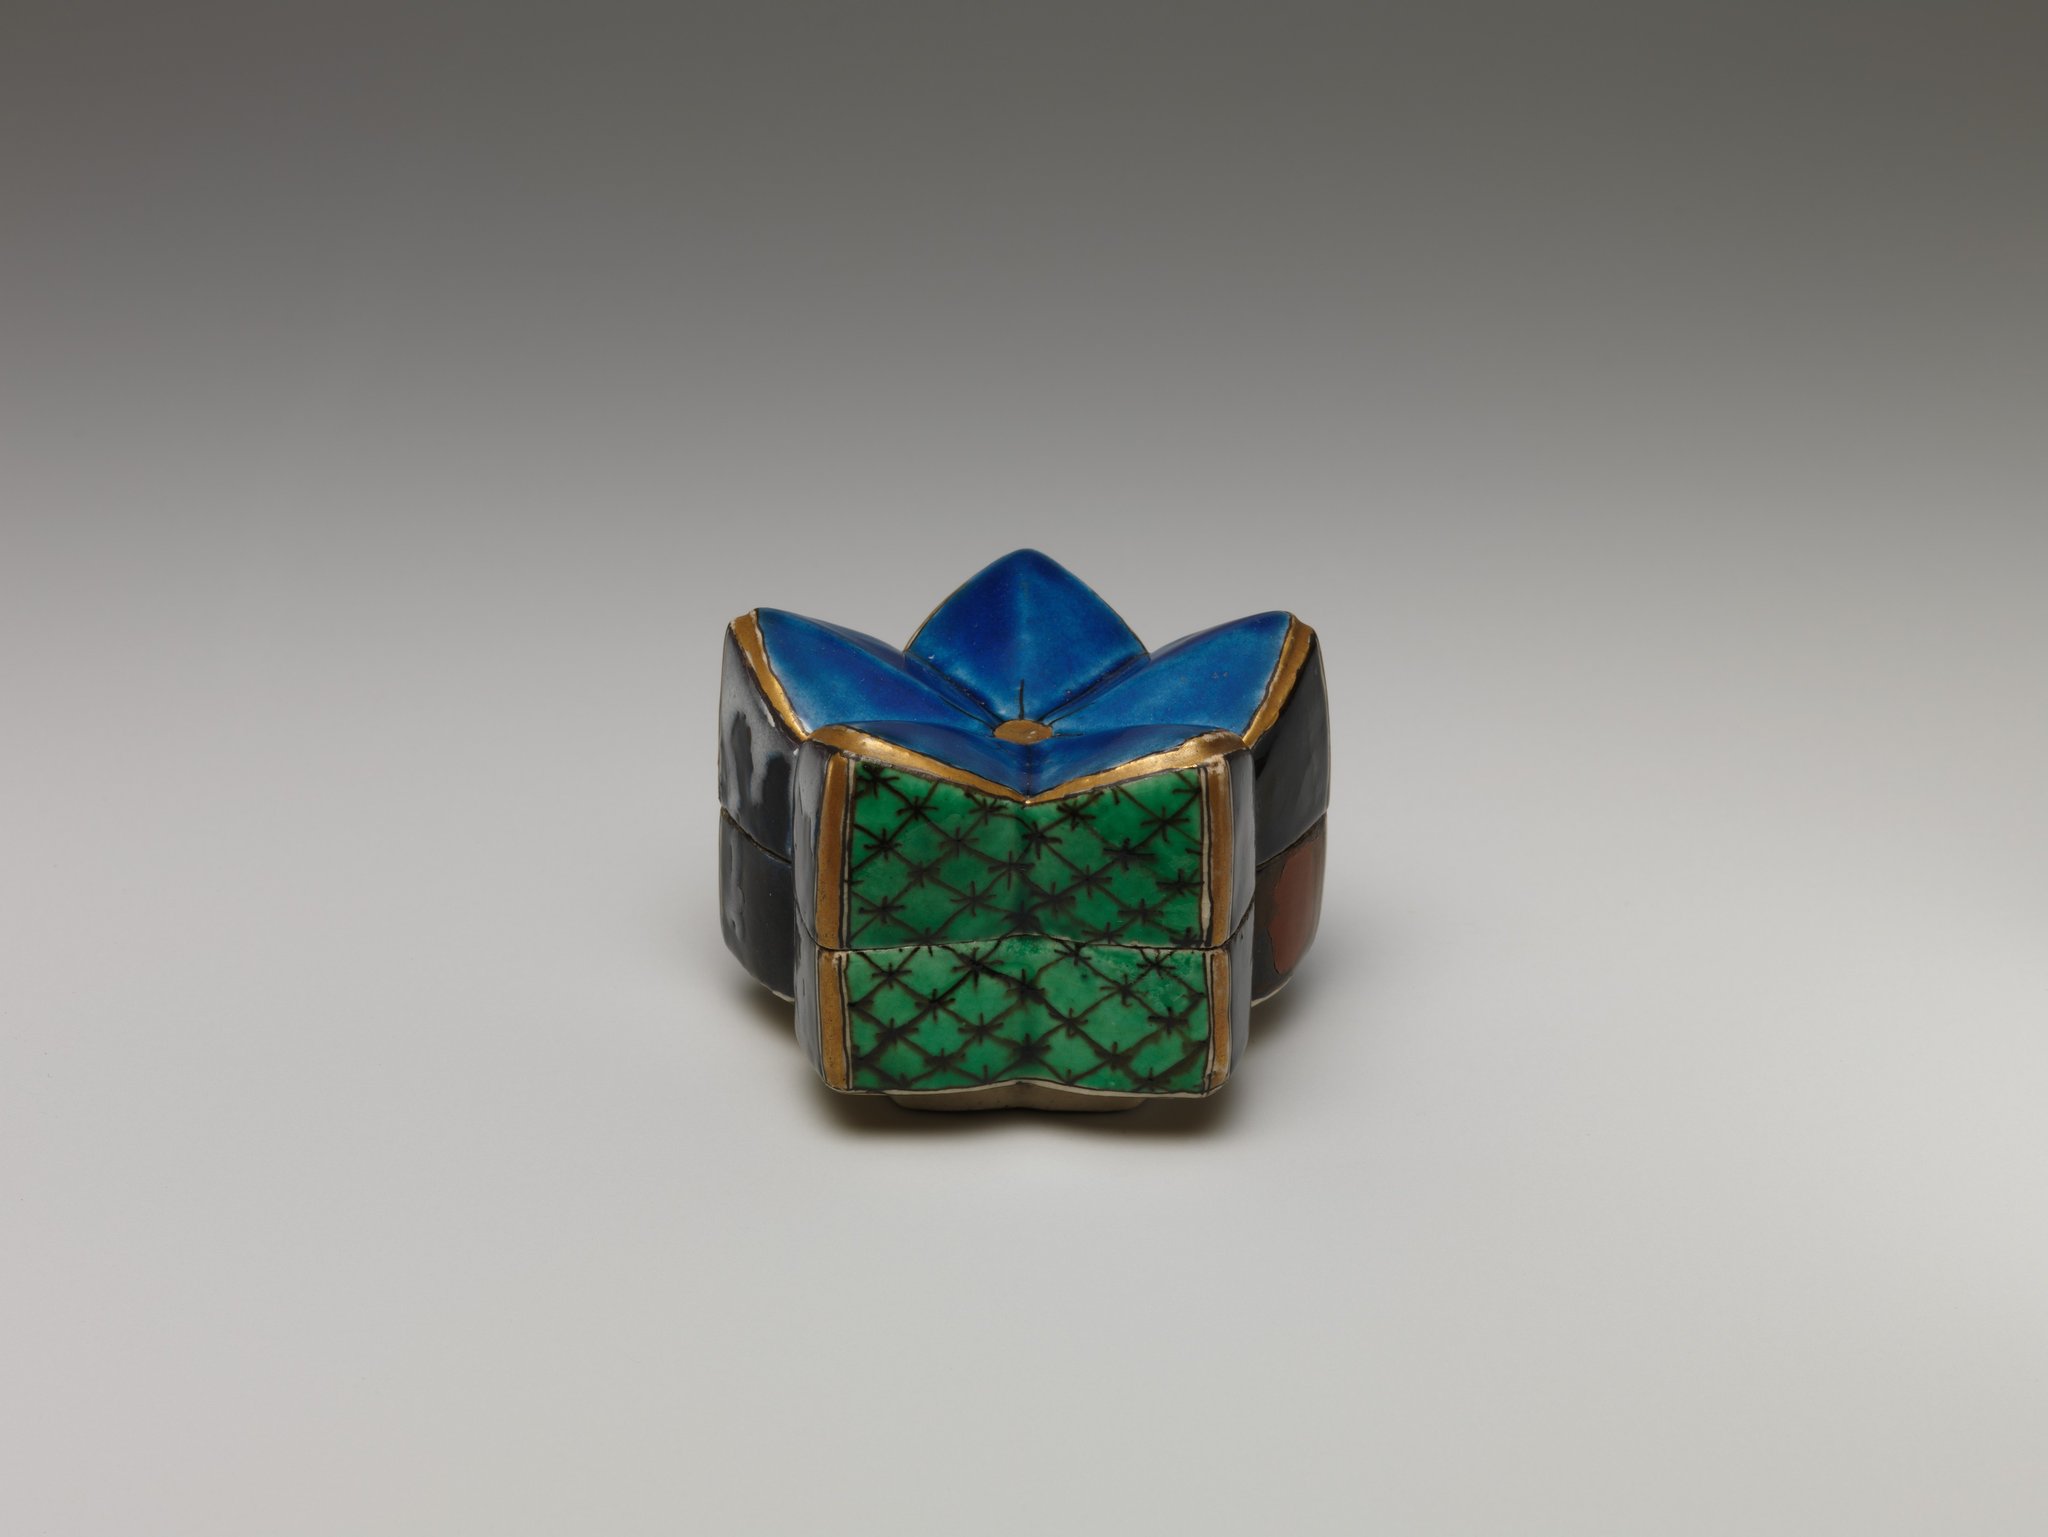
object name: incense box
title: Incense Box (Kōgō) in the Shape of a Plum Blossom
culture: japanese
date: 1801-1850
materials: enamel, gold, porcelain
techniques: overglaze, polychrome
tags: flowers